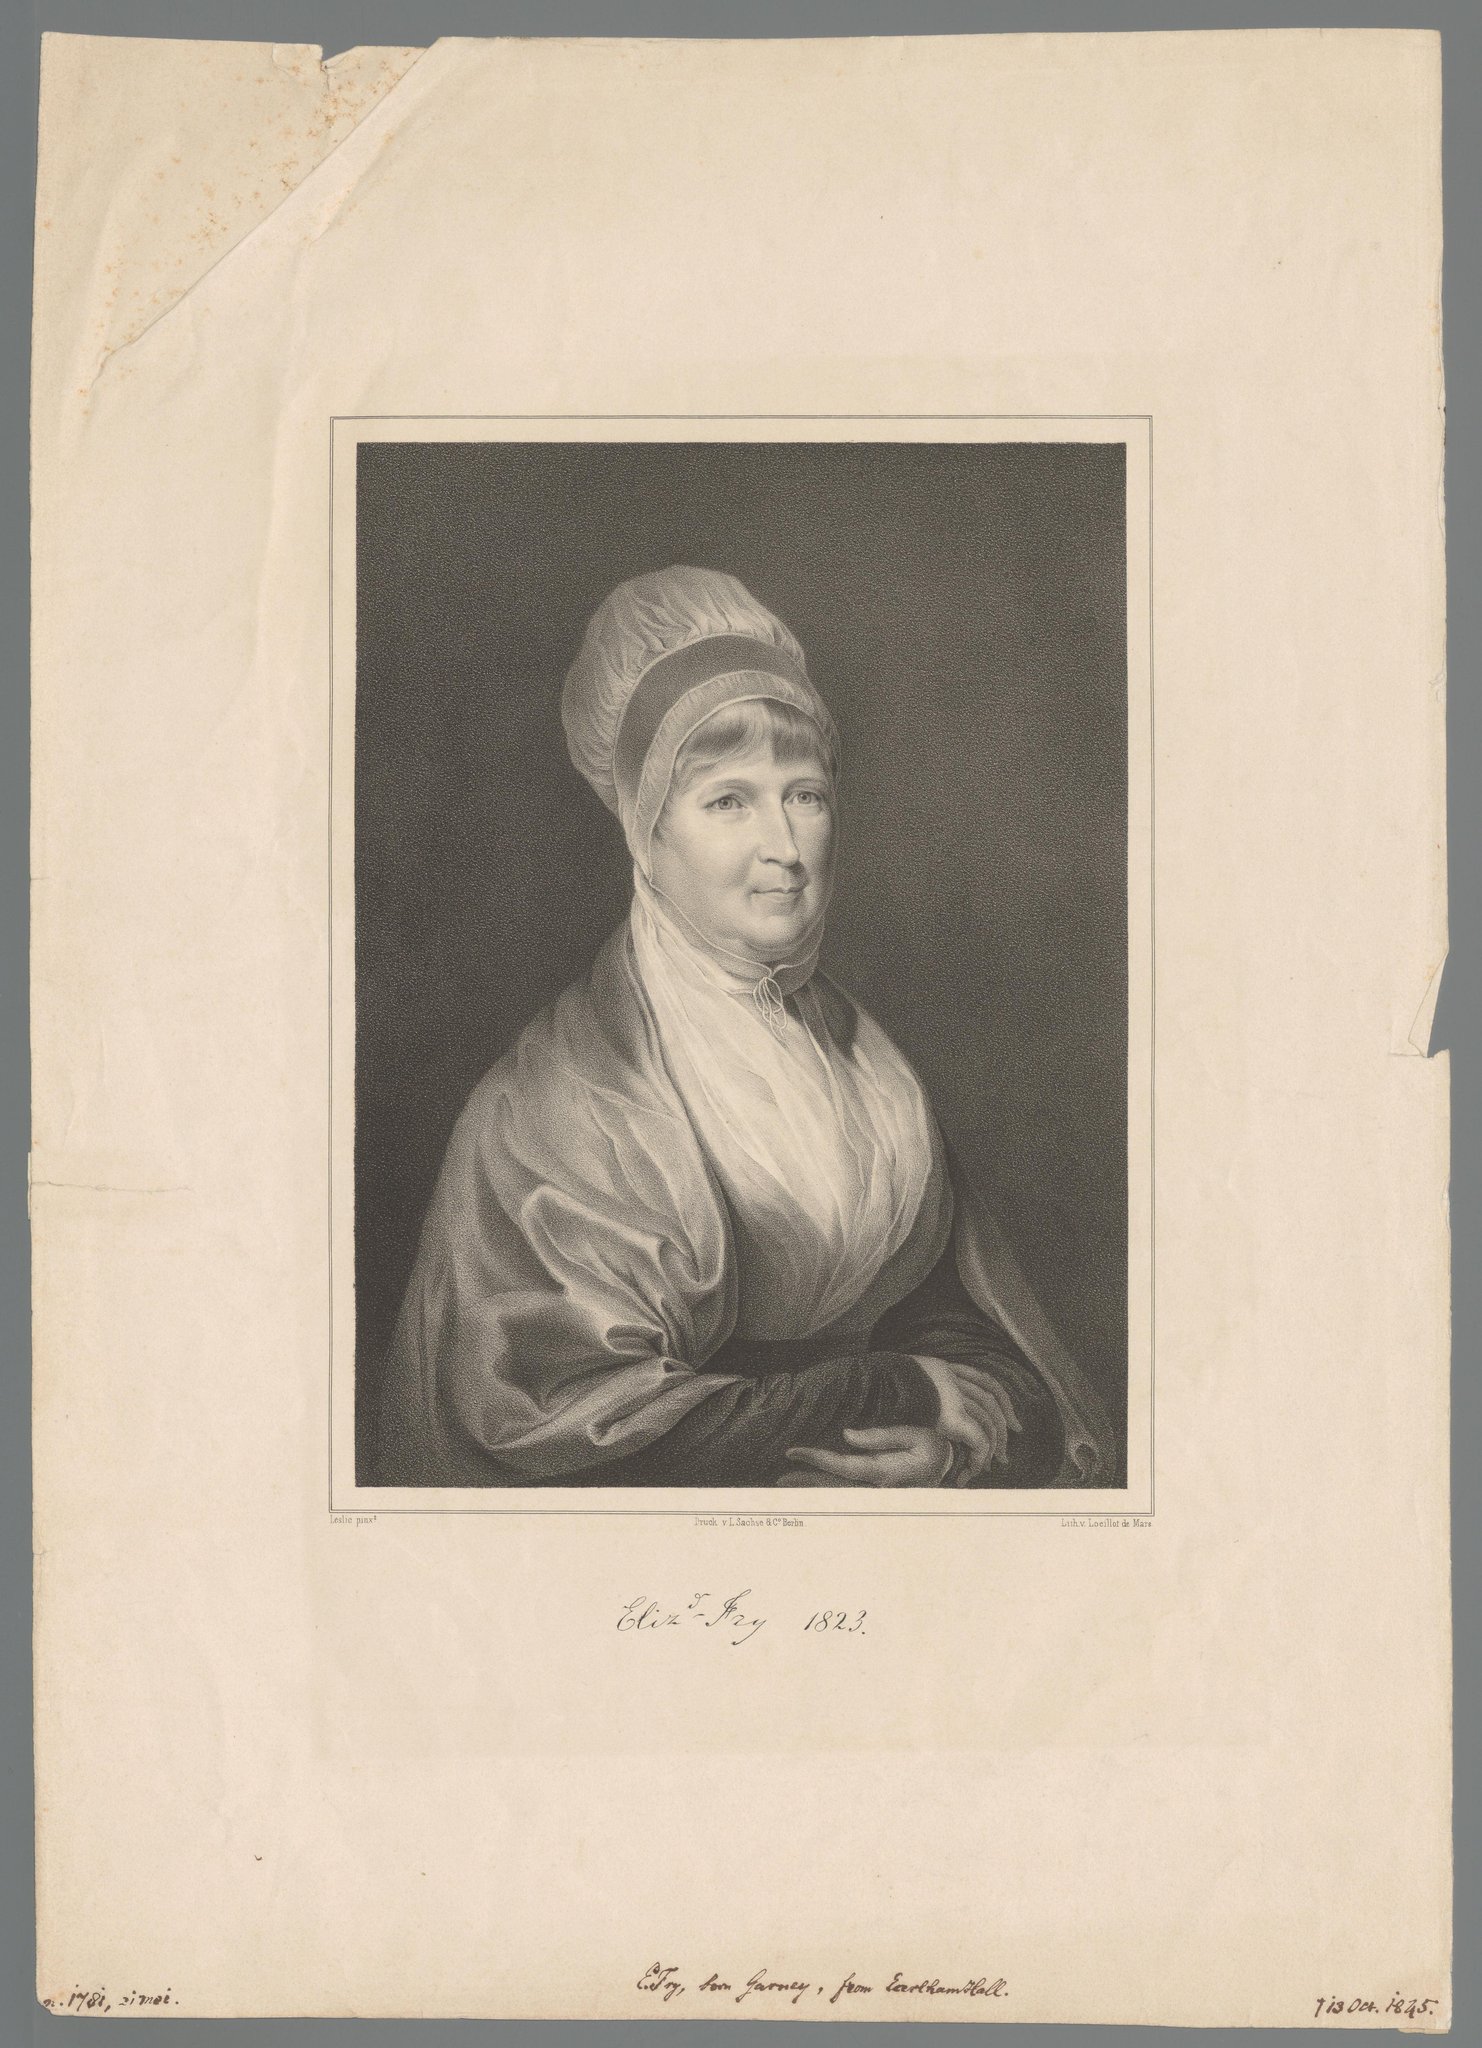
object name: print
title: Portret van Elizabeth Fry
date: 1832-1871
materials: paper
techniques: lithograph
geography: berlin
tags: historical persons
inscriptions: collector's mark: Lugt 2228